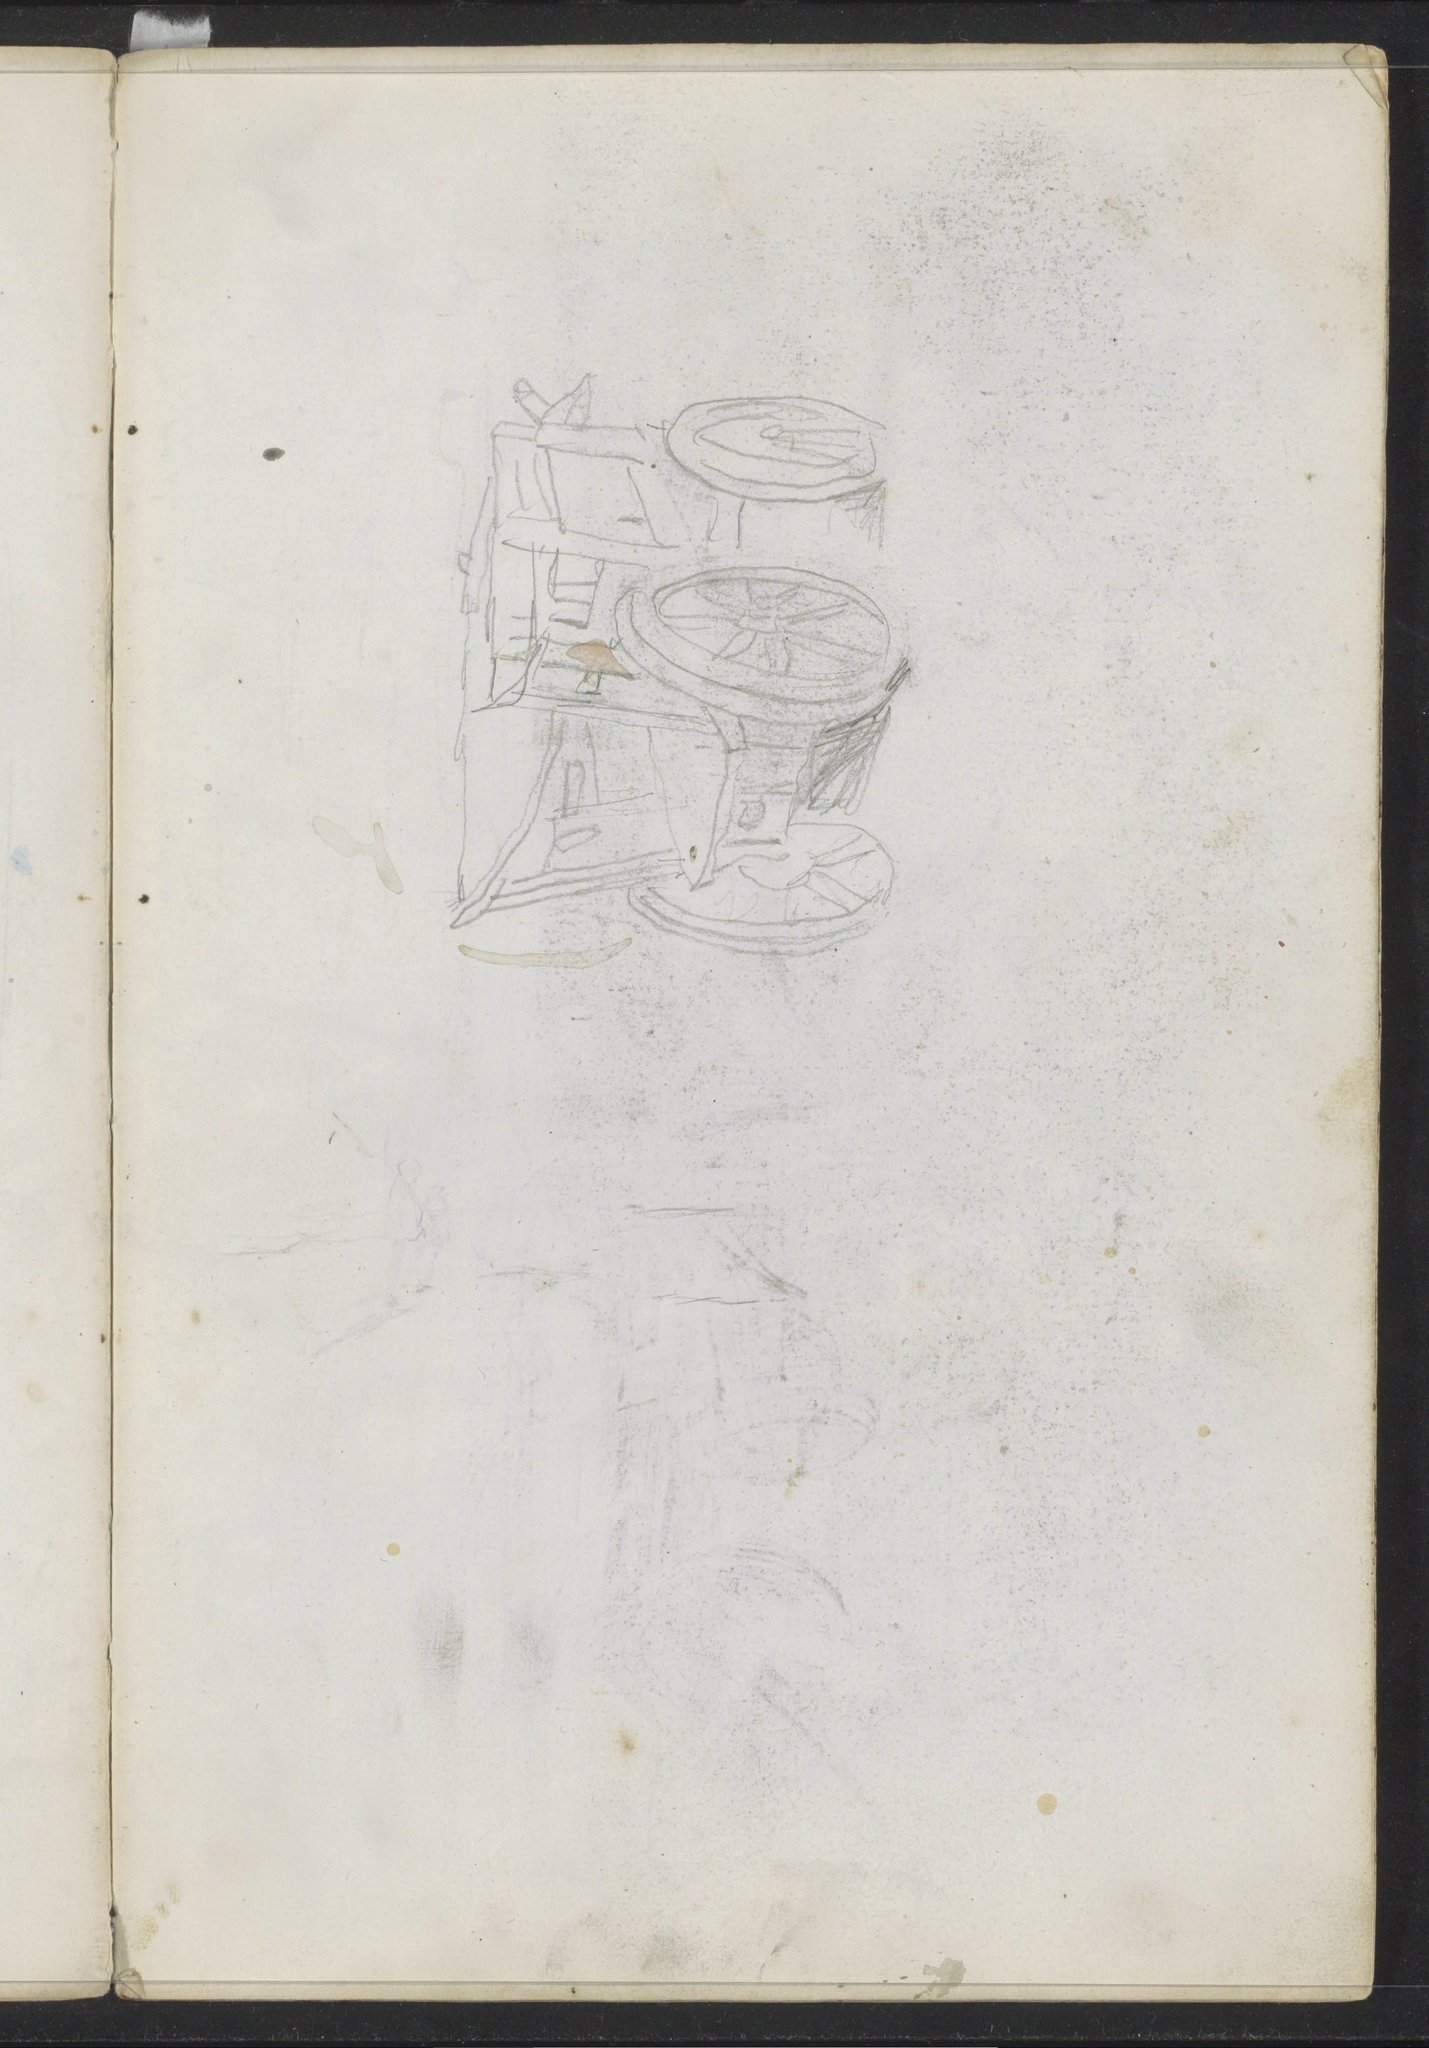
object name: sketchbook leaf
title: Kar met vier wielen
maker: jozef israëls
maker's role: draughtsman, painter, print maker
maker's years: 1824-1911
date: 1855-1859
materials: paper, pencil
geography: zandvoort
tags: four-wheeled, animal-drawn vehicle, e.g.: cab, carriage, coach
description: Blad 18 recto uit een schetsboek met 22 bladen.